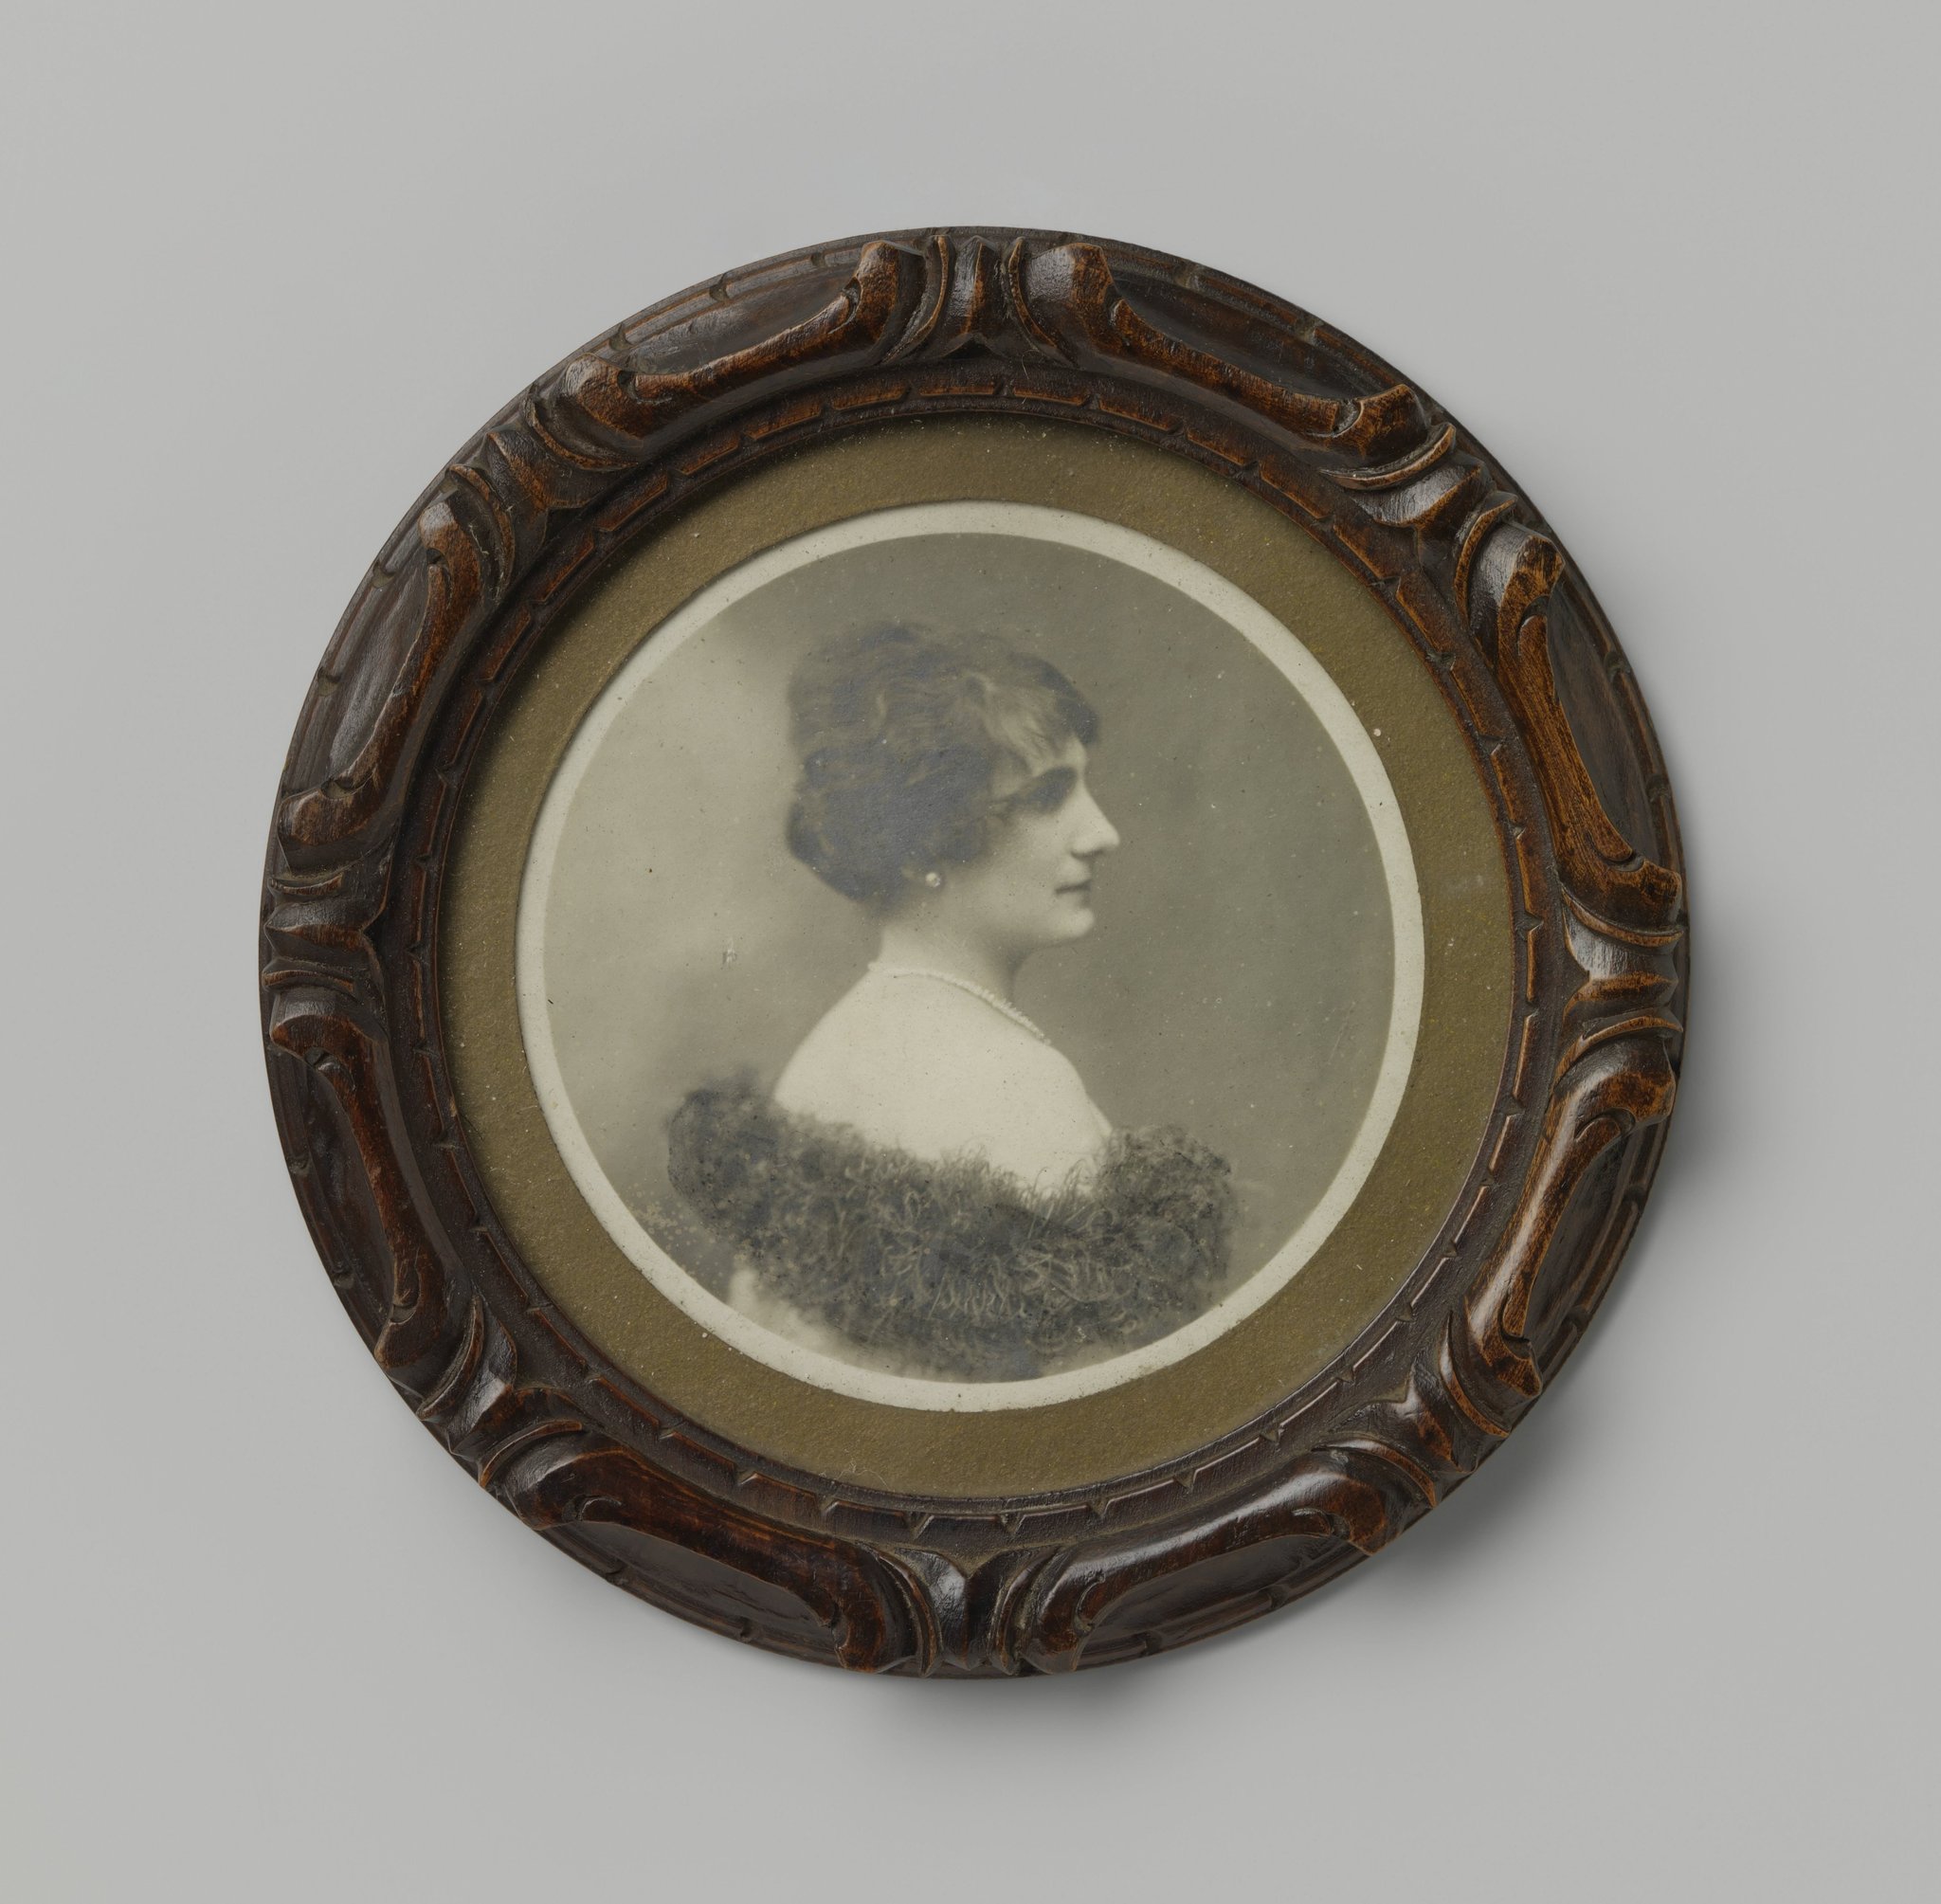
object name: photograph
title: Photo Frames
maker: Anonymous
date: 1880-1900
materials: paper, cardboard, glass, wood, metal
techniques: gelatin silver print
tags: necklace, anonymous historical person portrayed - bb - woman